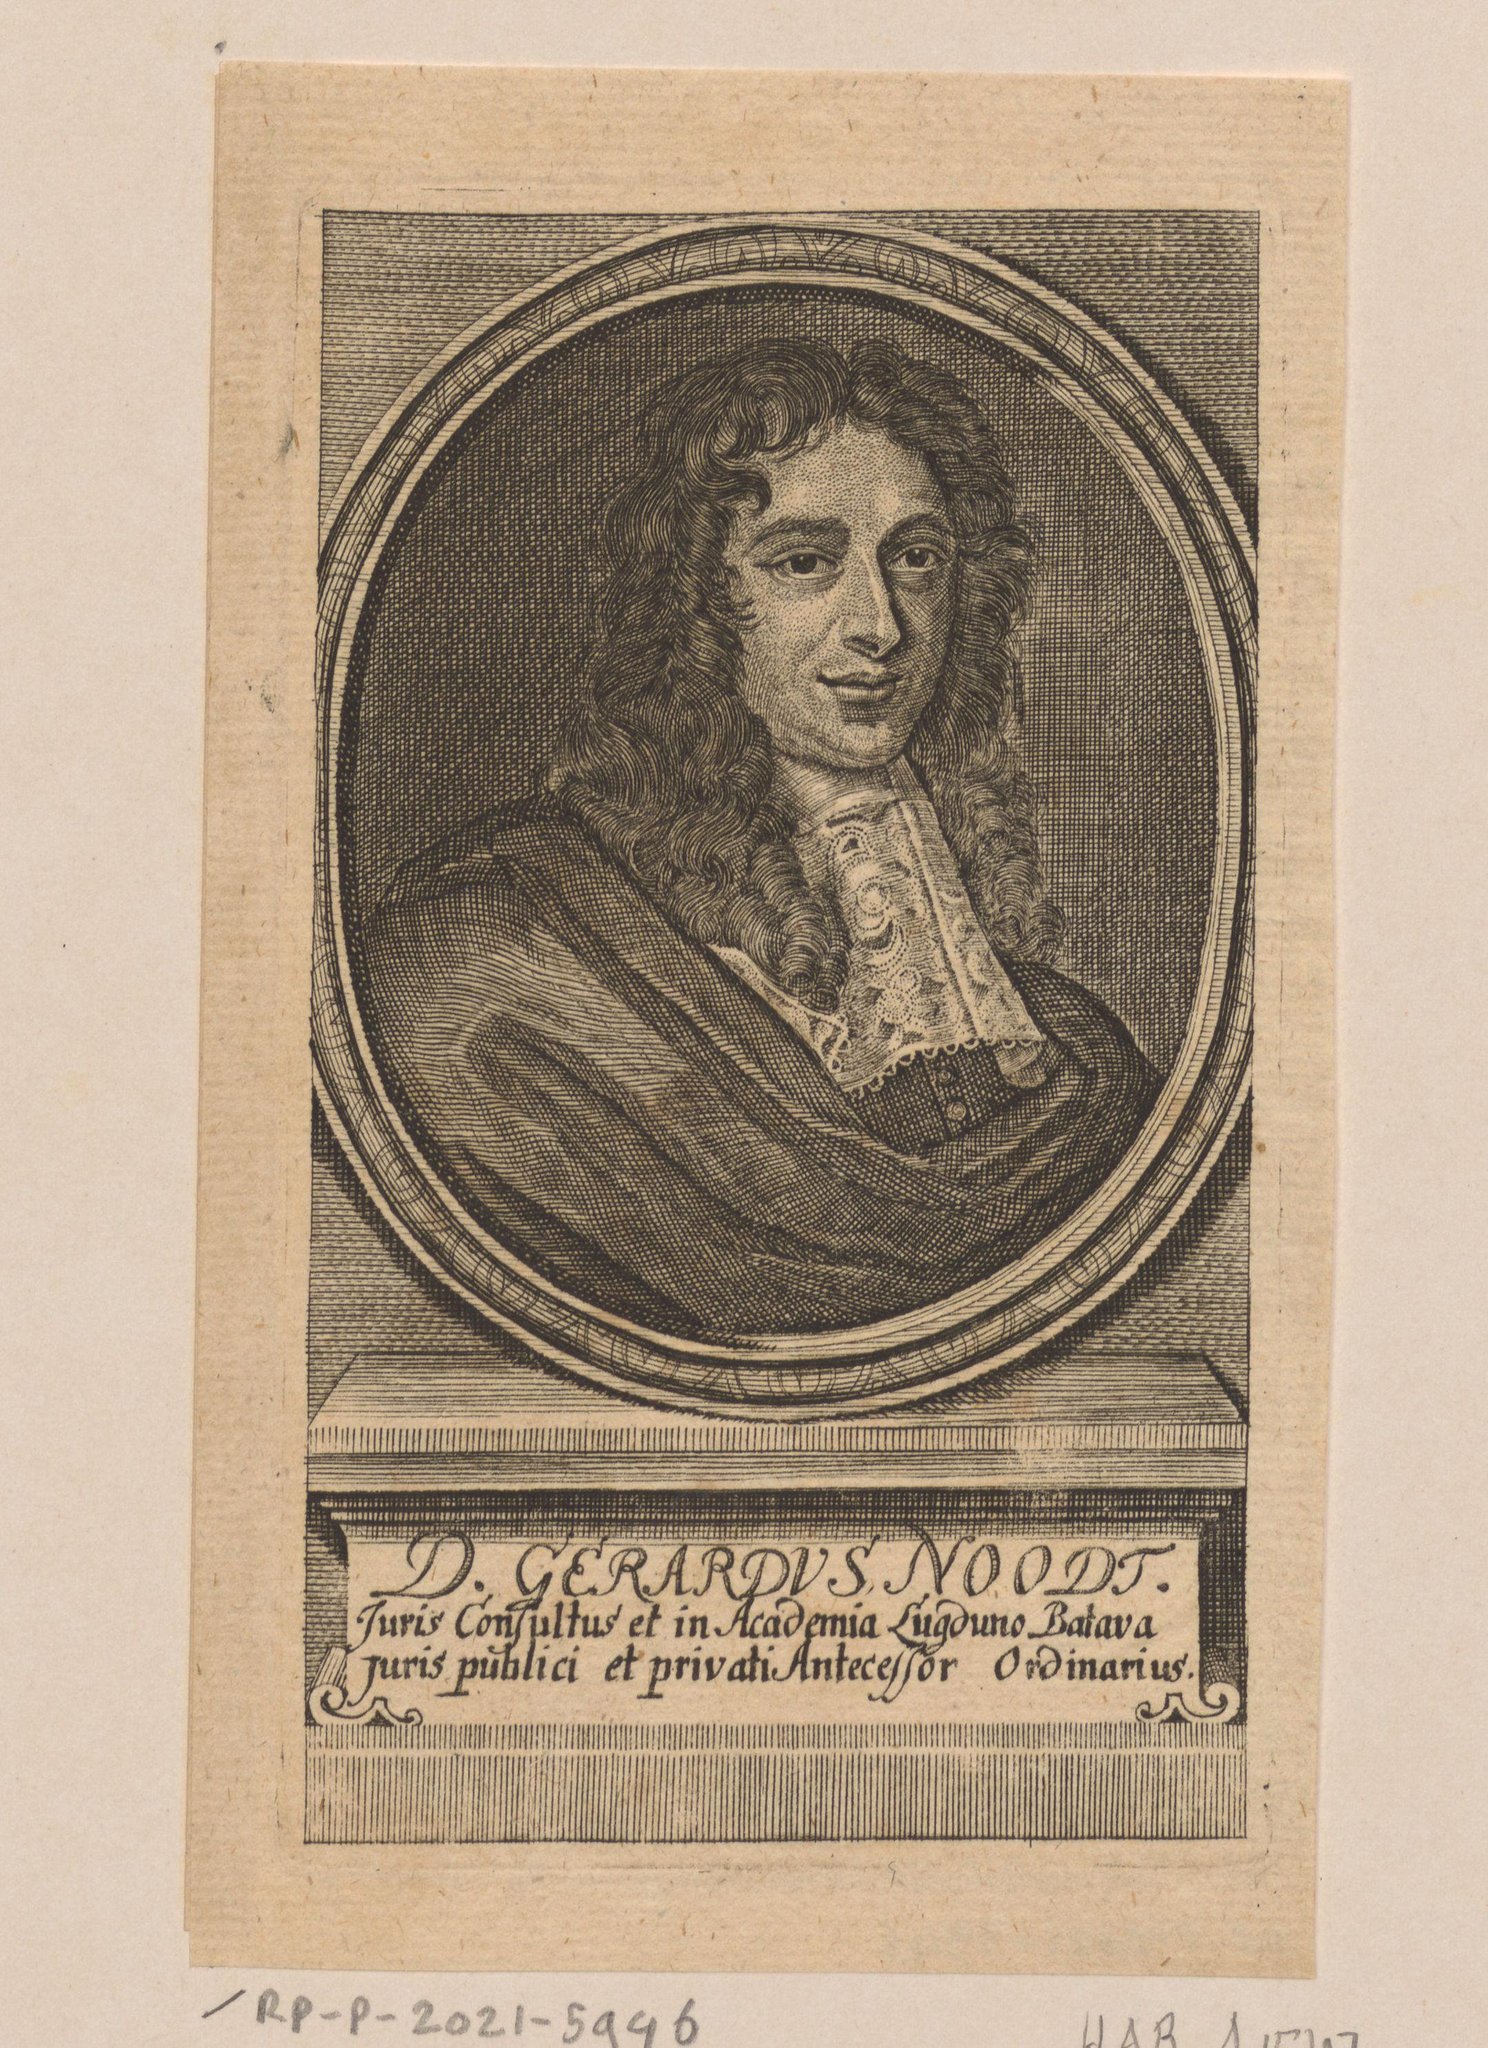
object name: print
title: Portret van Gerard Noodt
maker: Anonymous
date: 1710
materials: paper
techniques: engraving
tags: nijmegen, historical persons, law and jurisprudence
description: Prent waarschijnlijk uit: Neue Bibliothec oder Nachricht und Urtheile von neuen Büchern und allerhand zur Gelehrsamkeit dienenden Sachen. Frankfurt am Main en Leipzig: Rengerische Buchhandlung, 1710.